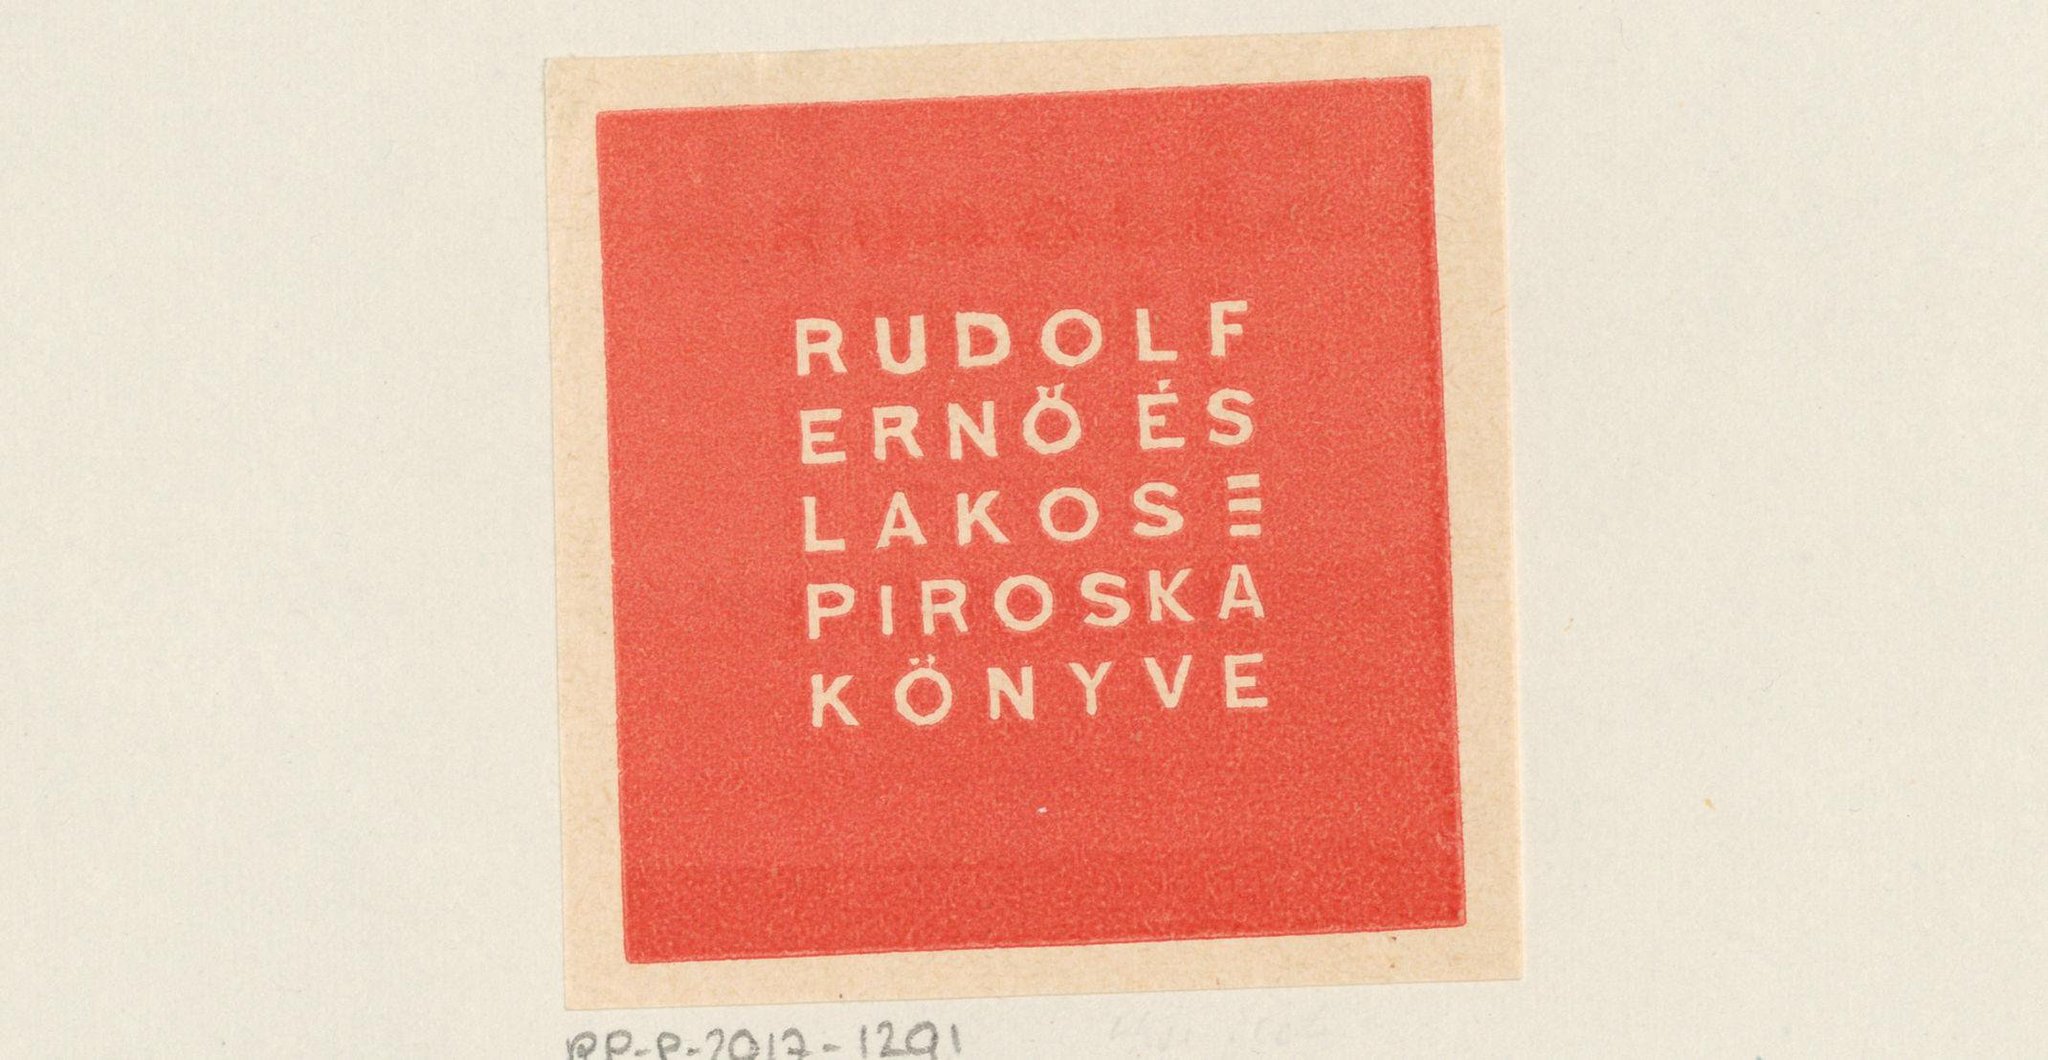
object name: bookplate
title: Ex libris van Ernö Rudolf en Piroska Lakos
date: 1900-1999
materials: paper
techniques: printing block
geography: hungary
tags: print maker, ernö rudolf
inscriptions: stamp: ‘ipse fecit’